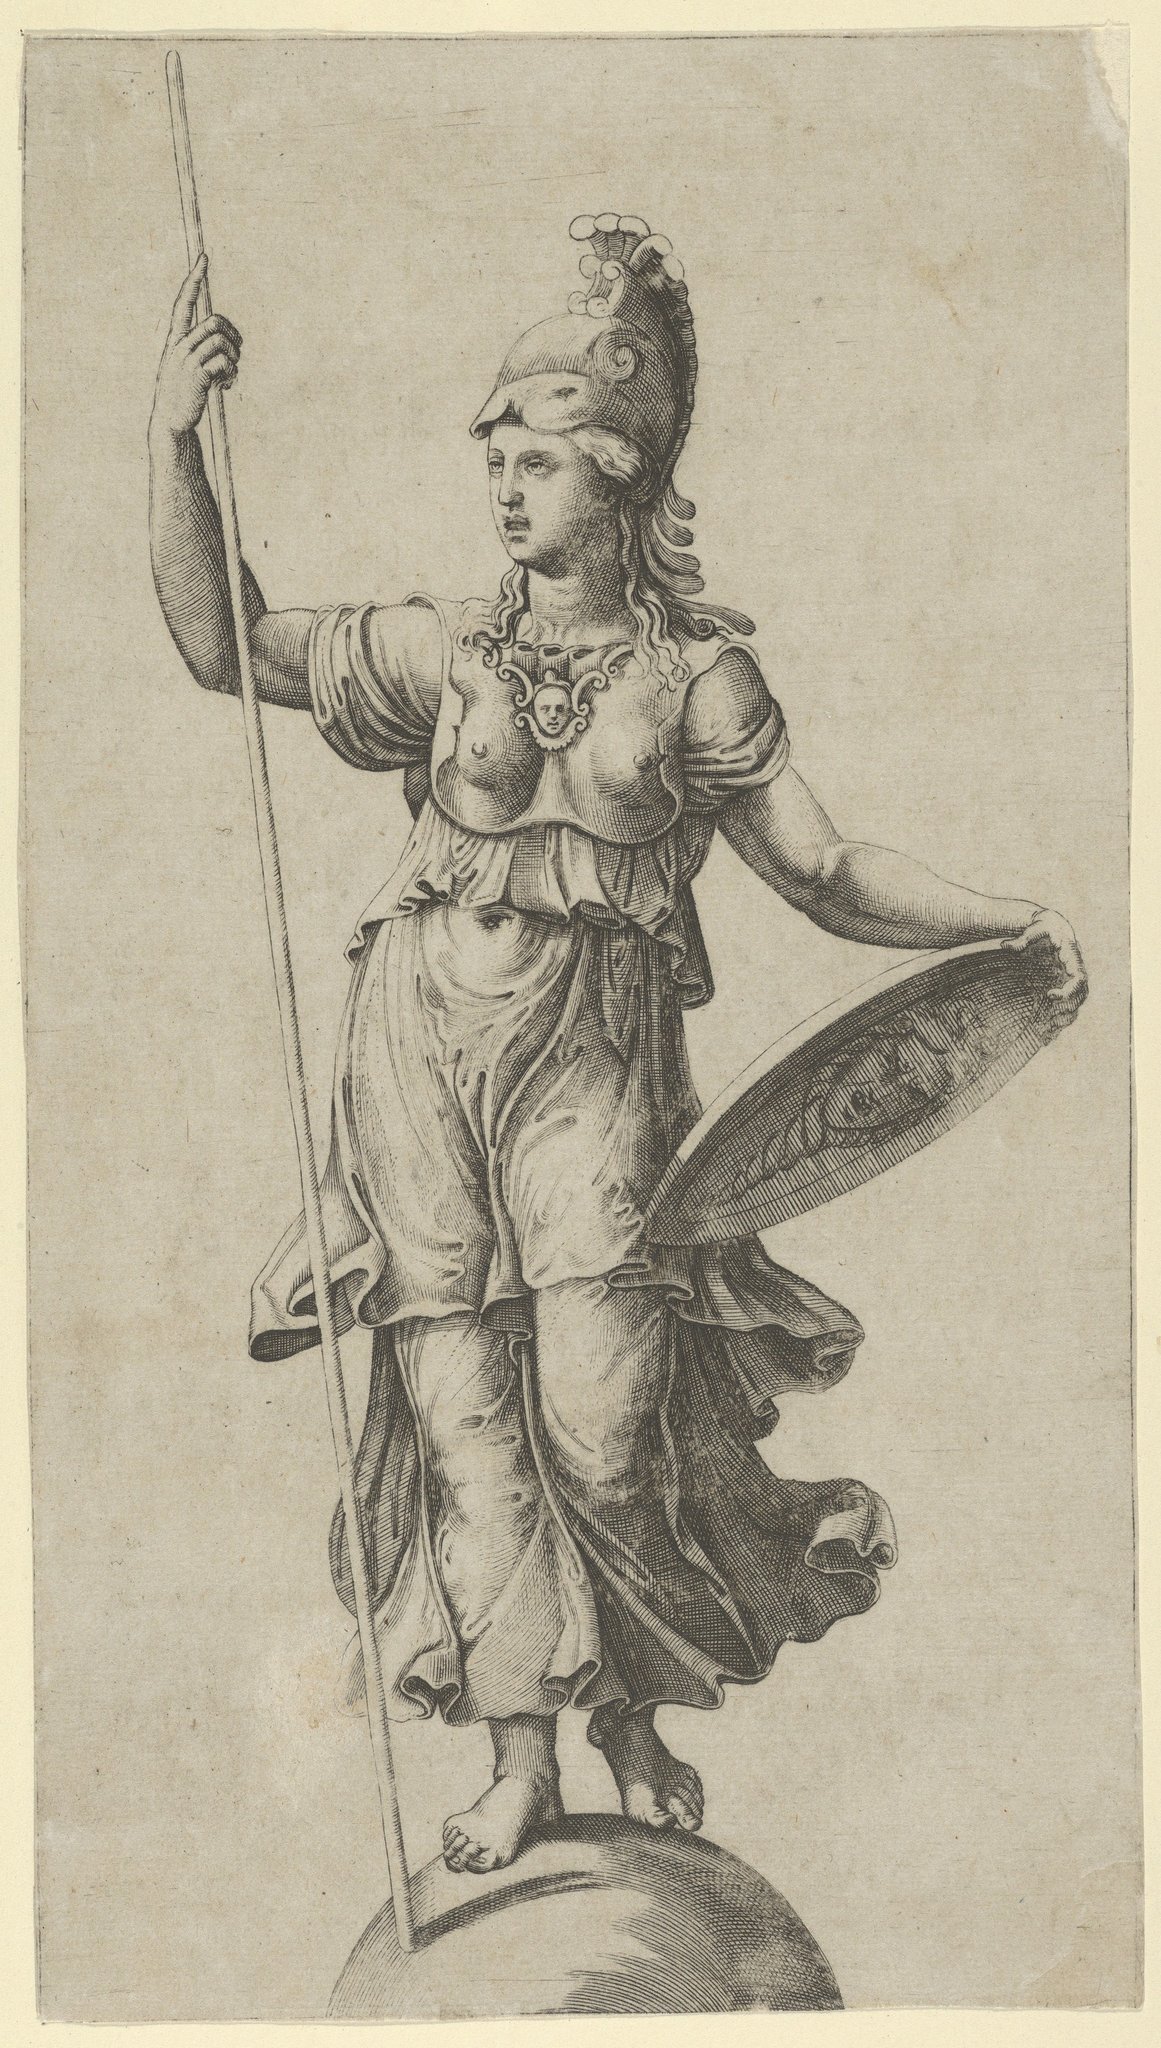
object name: print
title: Pallas Athena standing on a globe, holding a spear in her left hand and her shield in her right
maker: anonymous, italian, 16th to early 17th century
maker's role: artist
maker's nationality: italian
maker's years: 1500-1640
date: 1520-1527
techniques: engraving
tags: shields,spears,athena,globes